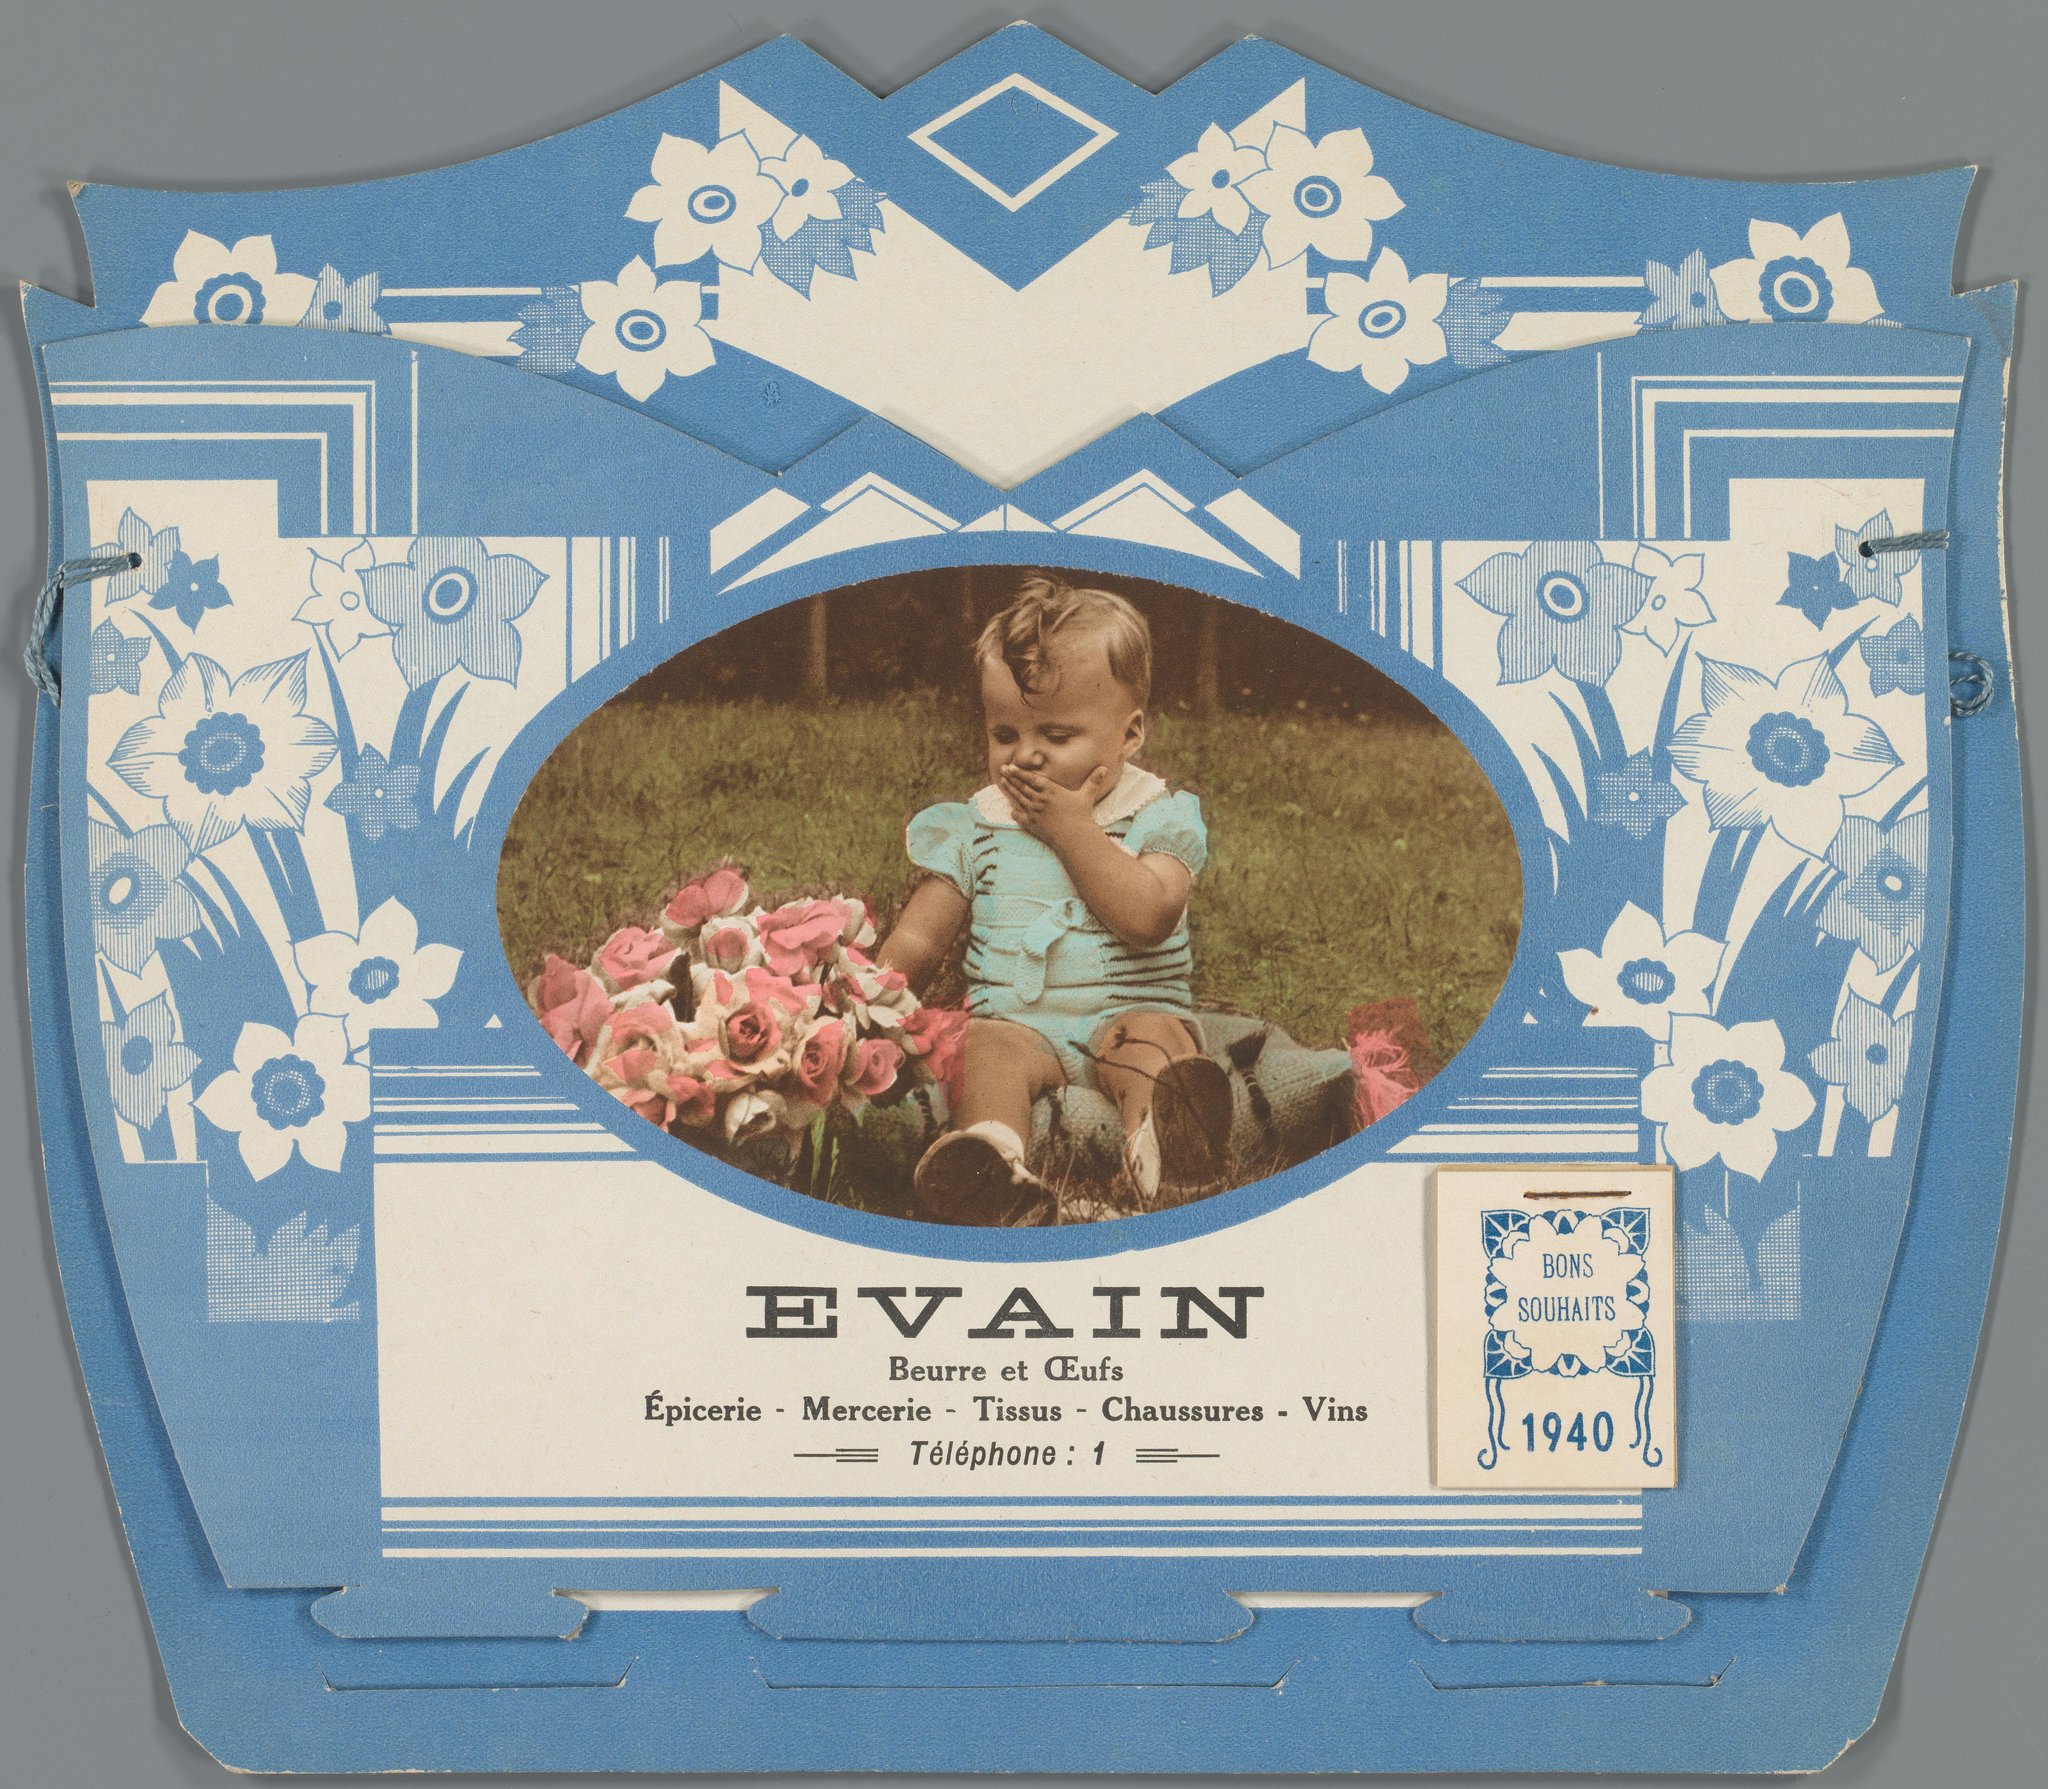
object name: calendar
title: Briefhouder met heiligenkalender voor 1940 van Evain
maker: Anonymous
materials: cardboard, cordage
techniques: hand coloring, printing block, rotogravure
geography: france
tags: calendar, almanac, infant, baby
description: Bouwpakket voor een briefhouder van de Franse kruidenier Evain met een portret van een onbekende baby en een heiligenkalender voor het jaar 1940.